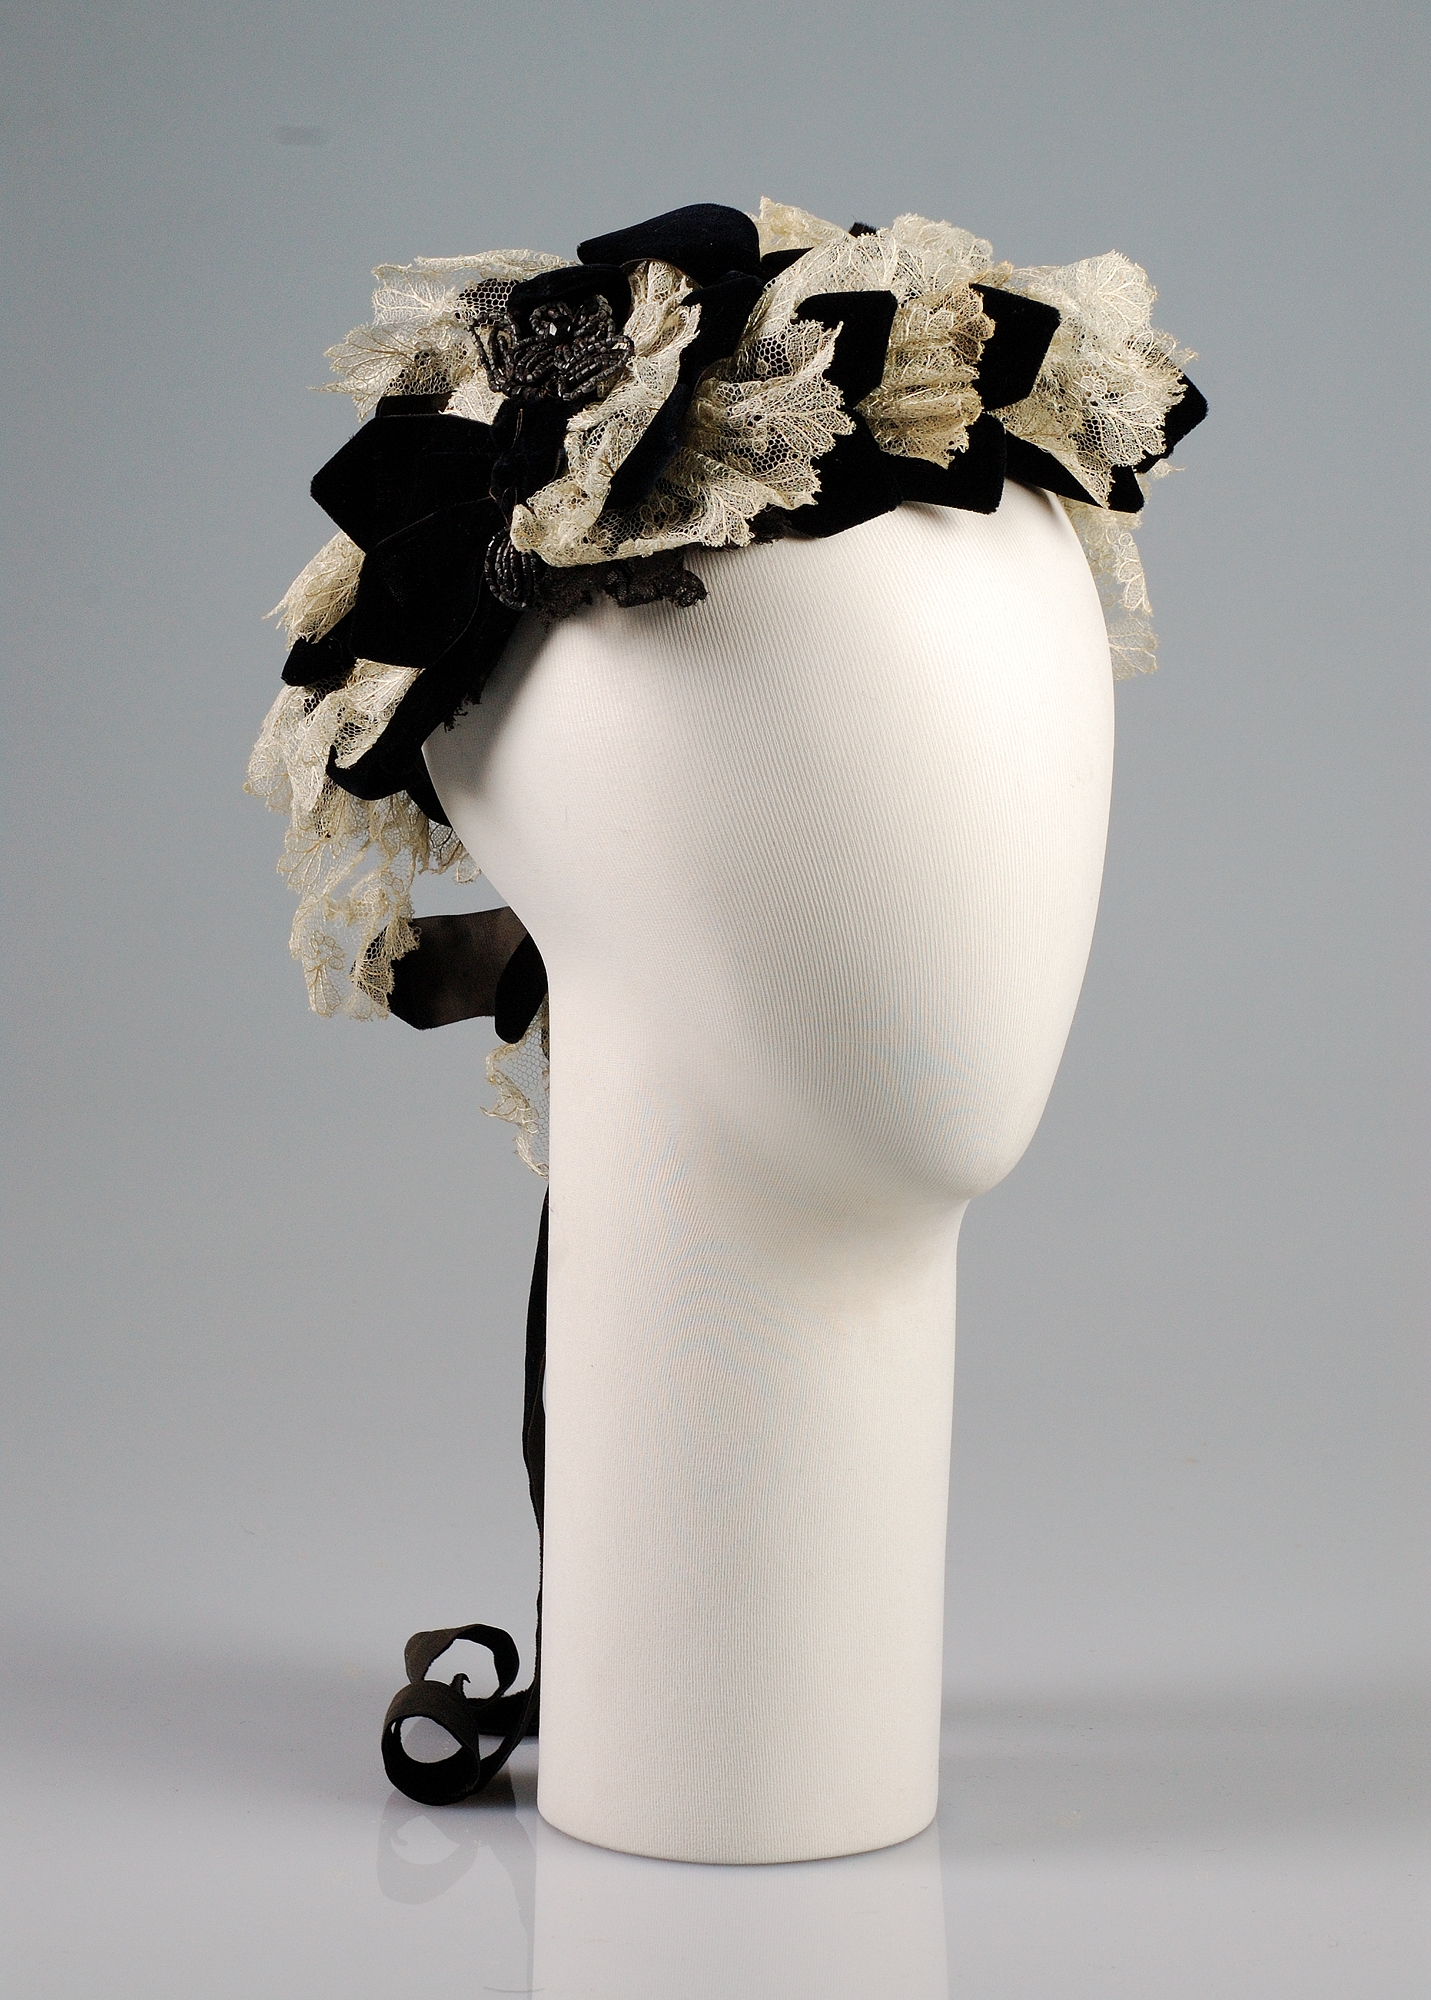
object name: bonnet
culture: american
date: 1875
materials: linen, silk